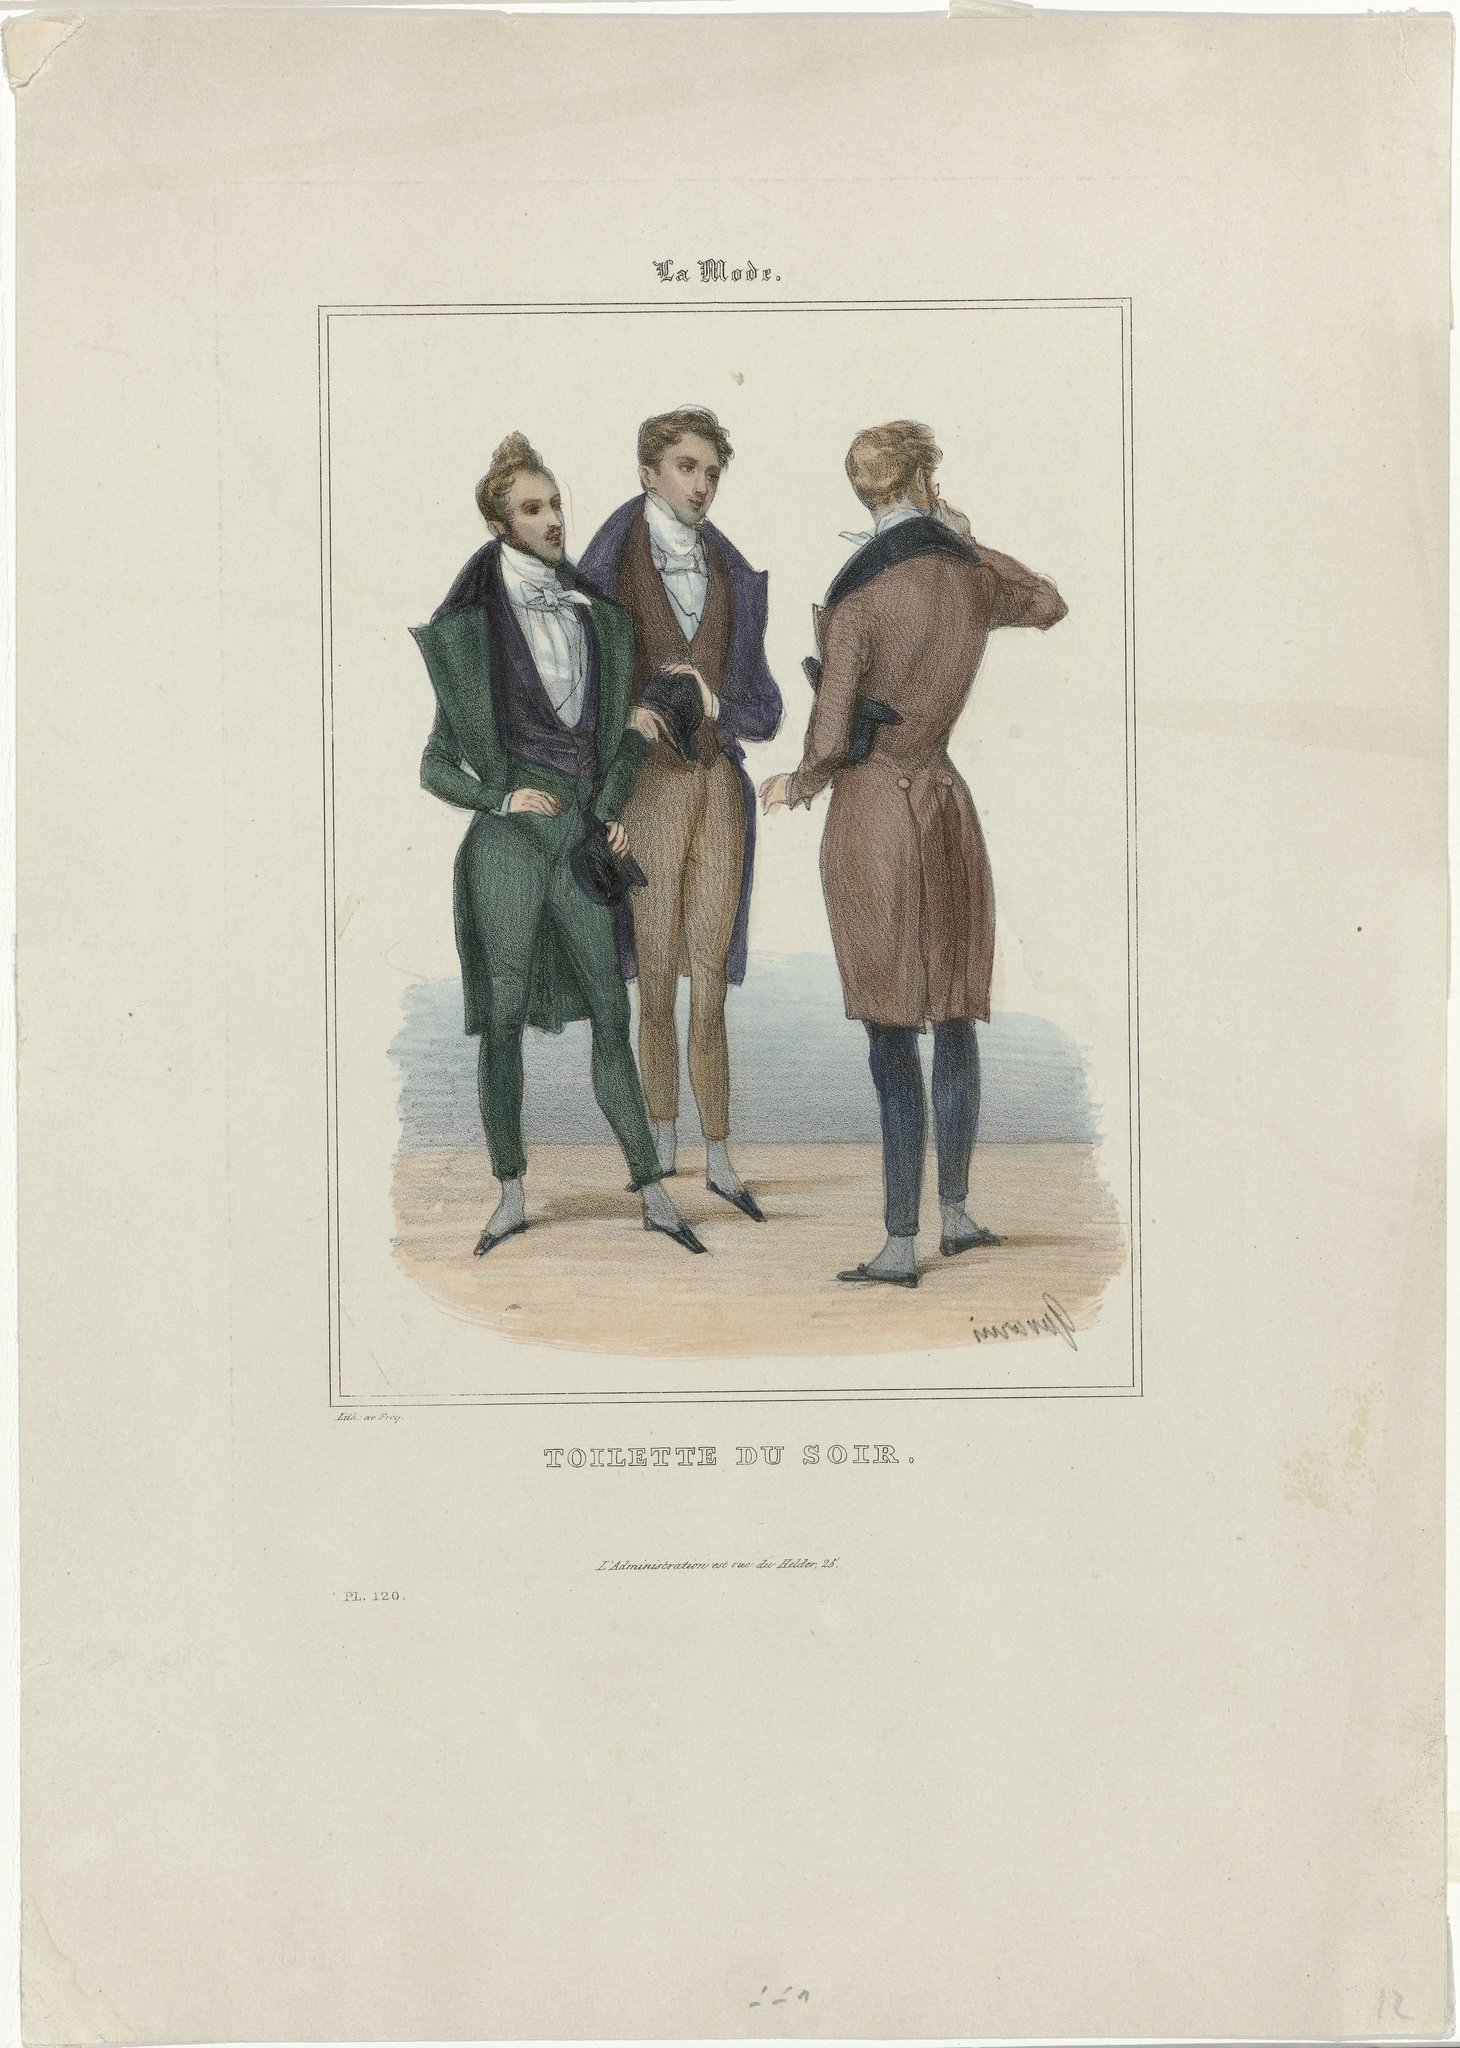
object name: fashion print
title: La Mode, 1831, Pl. 120 : Toilette du soir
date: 1831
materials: paper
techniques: hand coloring, lithograph, engraving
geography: paris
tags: clothing for the upper part of the body (vest) (+ men's clothes), neck-gear ~ clothing (+ men's clothes), trousers, breeches, etc. (pantalon) (+ men's clothes), coat (+ men's clothes), ensembles of pieces of clothing (dress suit) (+ men's clothes), ensembles of pieces of clothing (evening dress) (+ men's clothes), head-gear: hat (+ men's clothes), fashion plates, shoes, sandals (+ men's clothes), stockings, socks (+ men's clothes)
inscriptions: caption: ‘Toilette du soir.’, title: ‘La Mode.’, address: ‘L'Administration est rue du Helder, 25.’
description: Drie mannen in avondkleding anno 1831: jas met brede revers, vest en lange broek. Geknoopte halsdoek, hoed in de hand. Platte schoenen met vierkante neuzen. Prent uit het modetijdschrift La Mode (1829-1855).